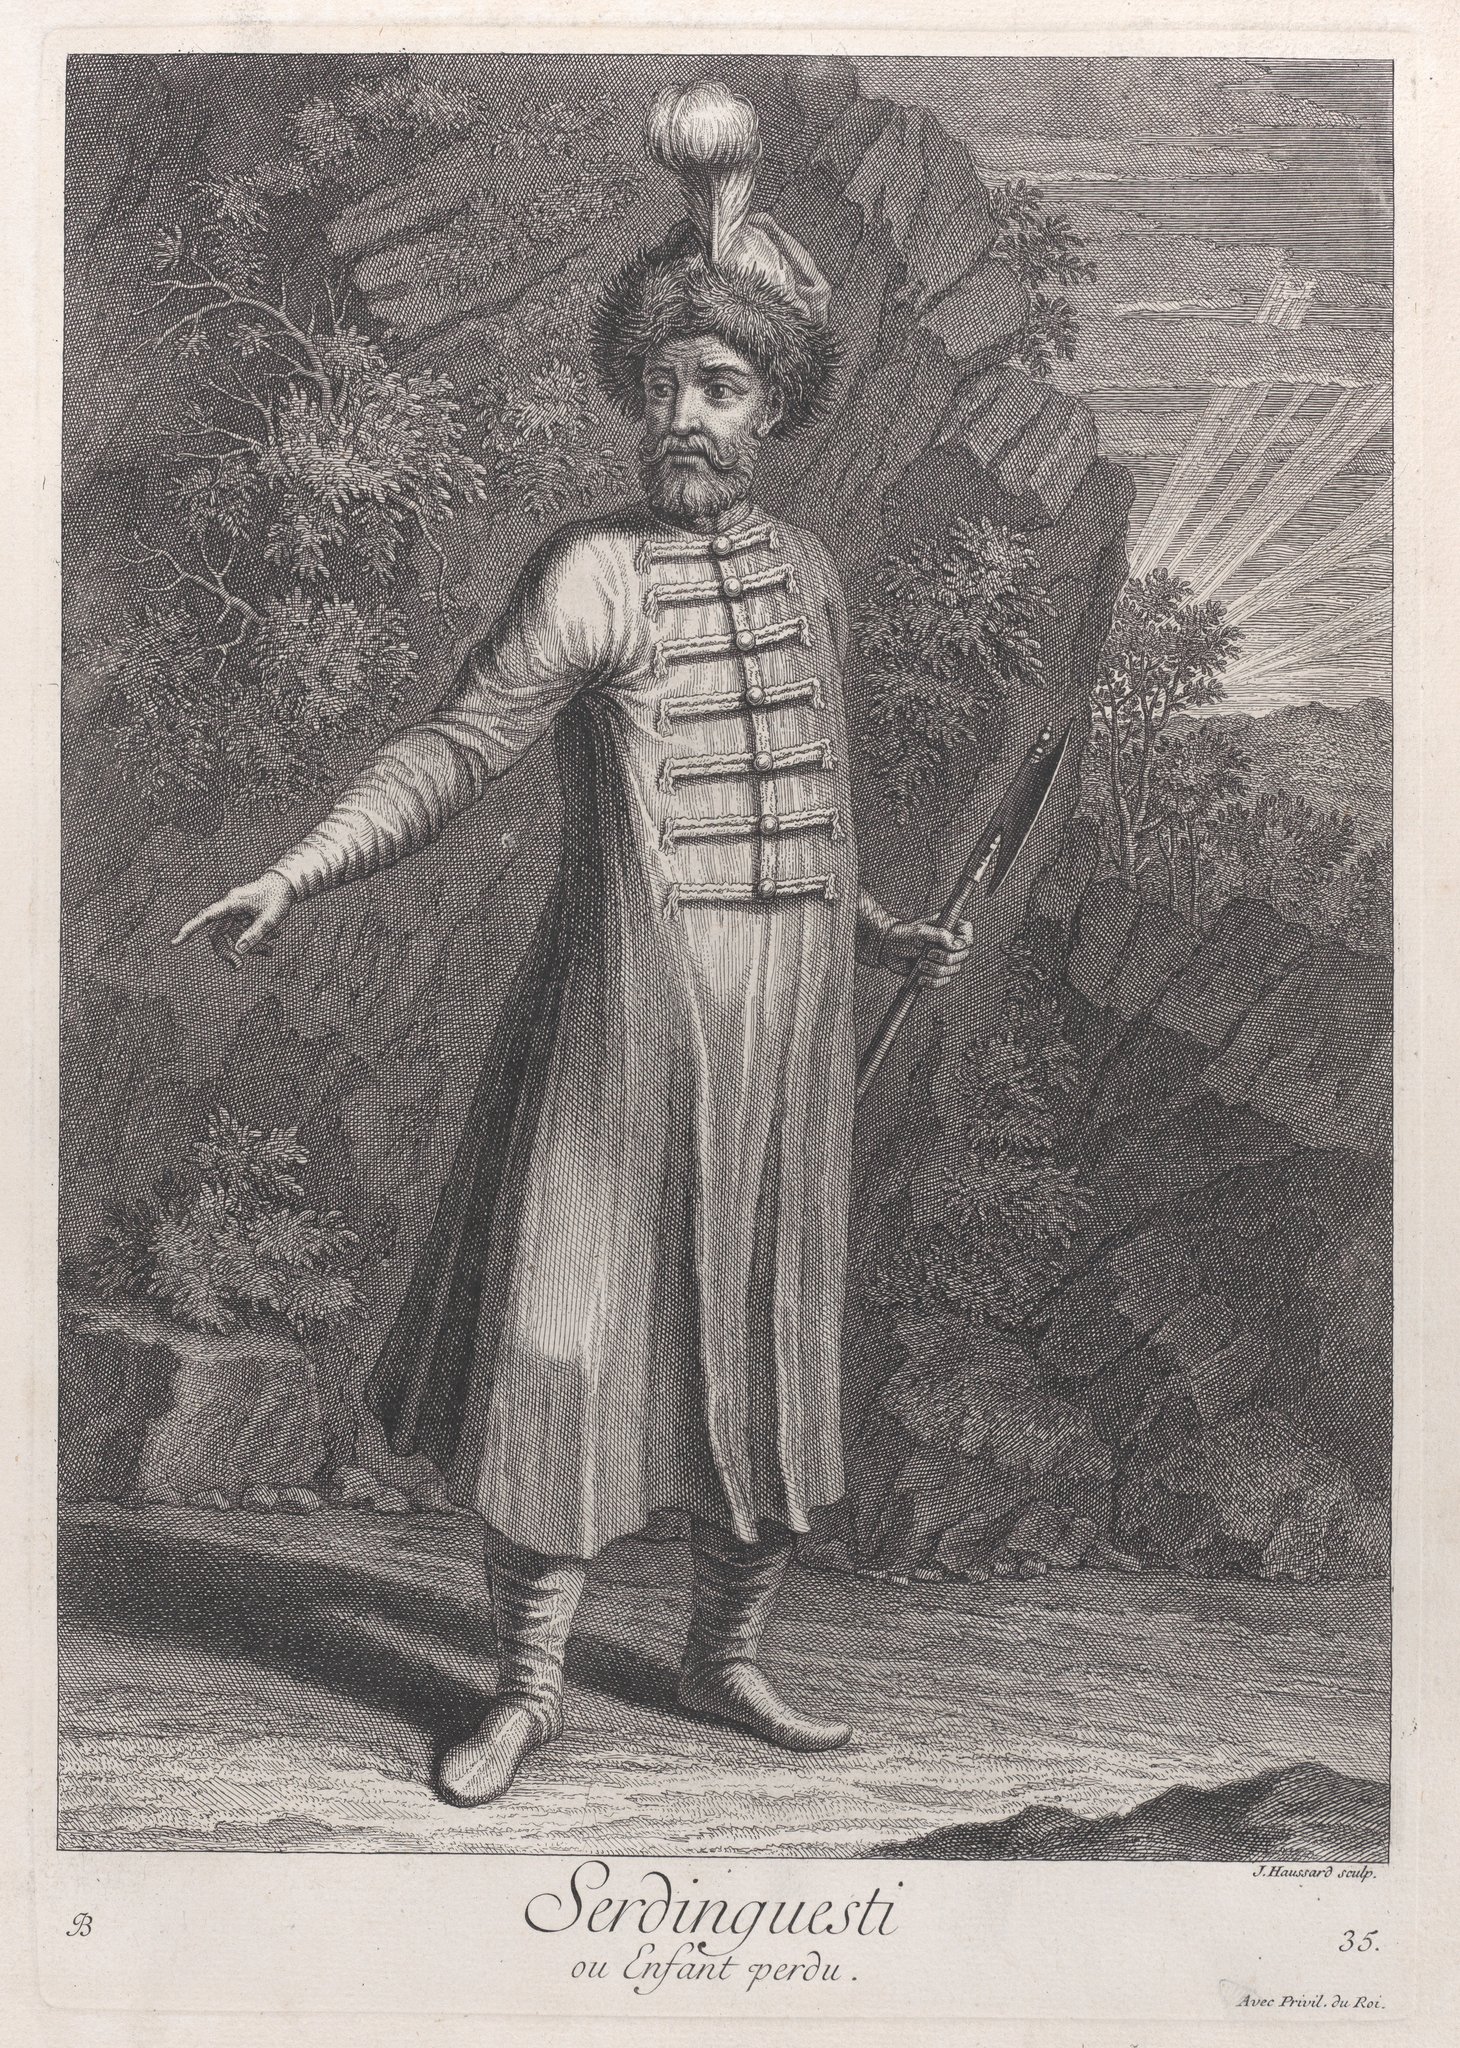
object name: print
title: Serdinguesti, ou enfant perdu, plate 35 from "Recueil de cent estampes représentent differentes nations du Levant"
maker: jean baptiste vanmour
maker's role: artist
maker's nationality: french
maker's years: 1671-1737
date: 1714-1715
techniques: engraving, etching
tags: men